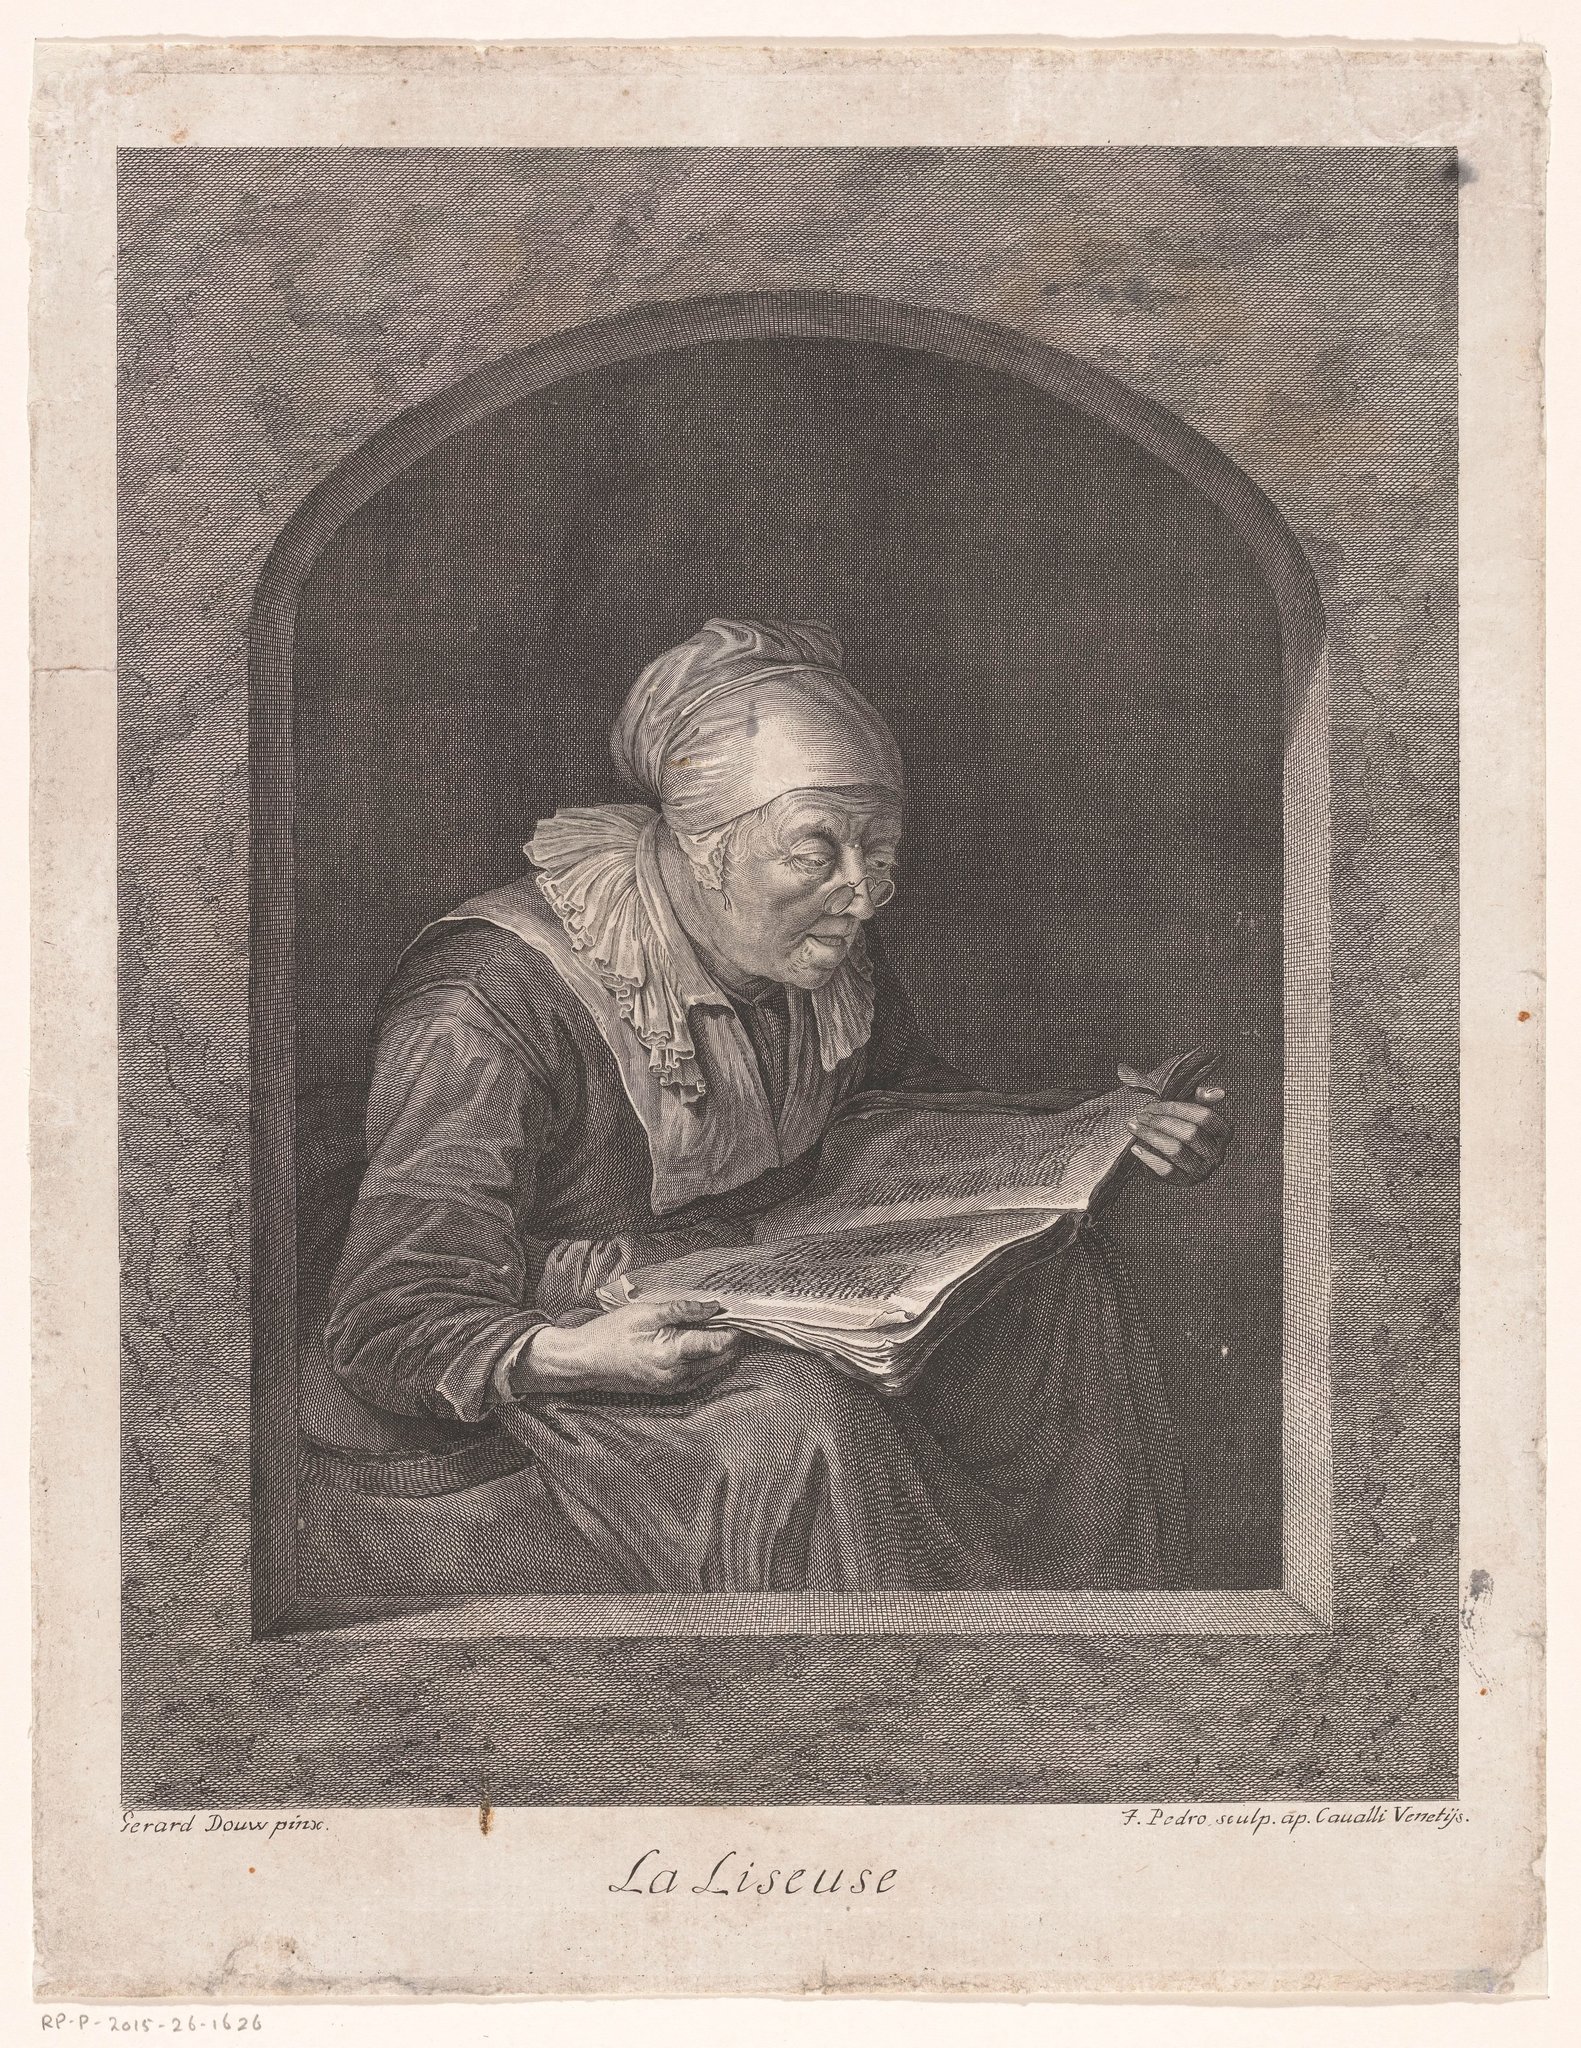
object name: print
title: Lezende oude vrouw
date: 1749-1806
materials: paper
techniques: etching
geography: venice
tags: reading, eyeglasses, spectacles - aa - female human figure, old woman, book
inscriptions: collector's mark: Lugt 4779, collector's mark: Lugt 2228, collector's mark: Lugt 4780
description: Portret van een lezende oude vrouw in een nis. Ze draagt een hoofddoek en op haar neus staat een pince-nez. Ze leest in een boek dat opengeslagen op haar knieën ligt.